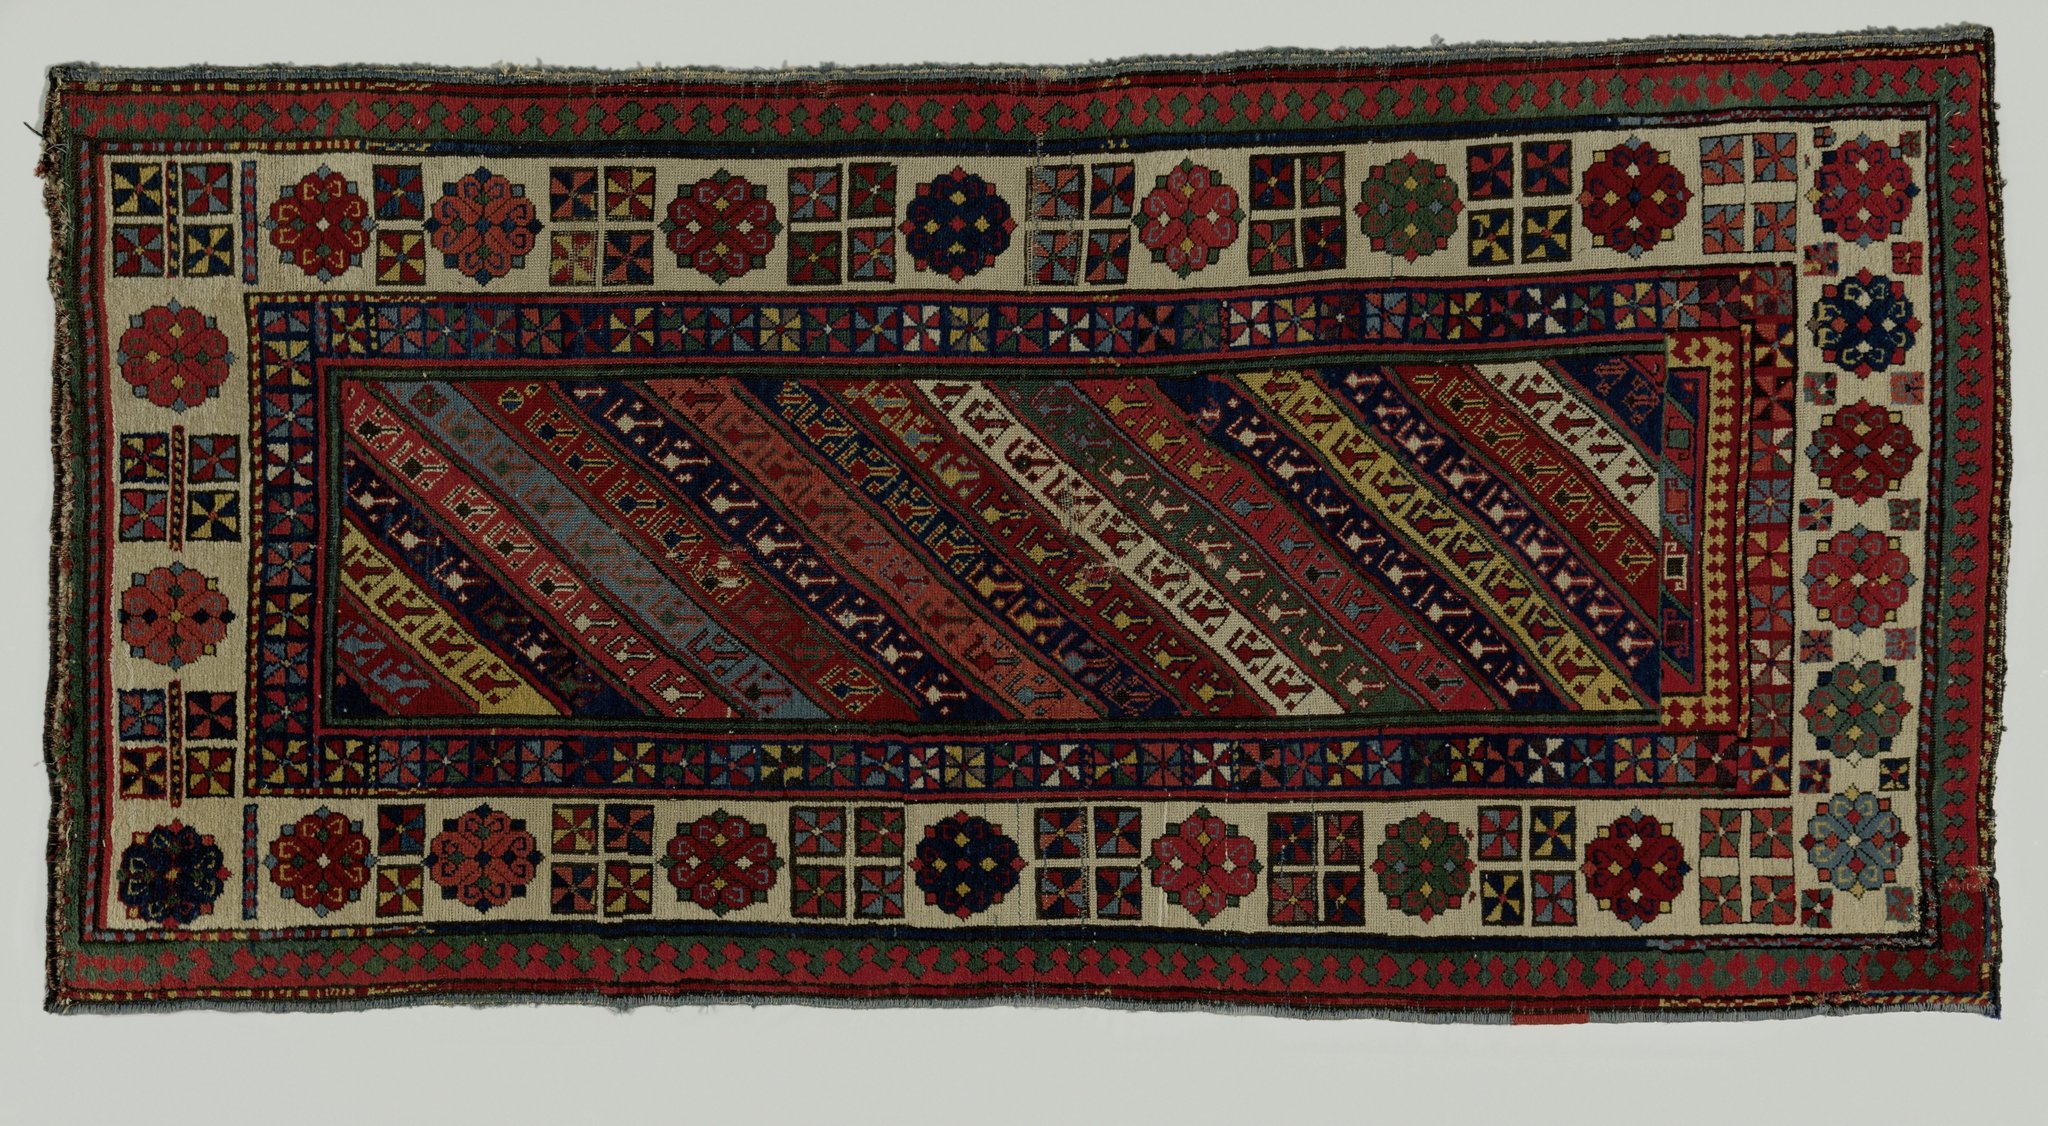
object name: oriental rug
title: Oosters tapijt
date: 1799-1899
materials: wool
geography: caucasus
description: Oosters tapijt waarvan het middenveld geheel gevuld is met diagonale strepen in diverse kleuren. De breedste rand is versierd met rozetten afgewisseld door kwadranten, tegen een witte achtergrond.